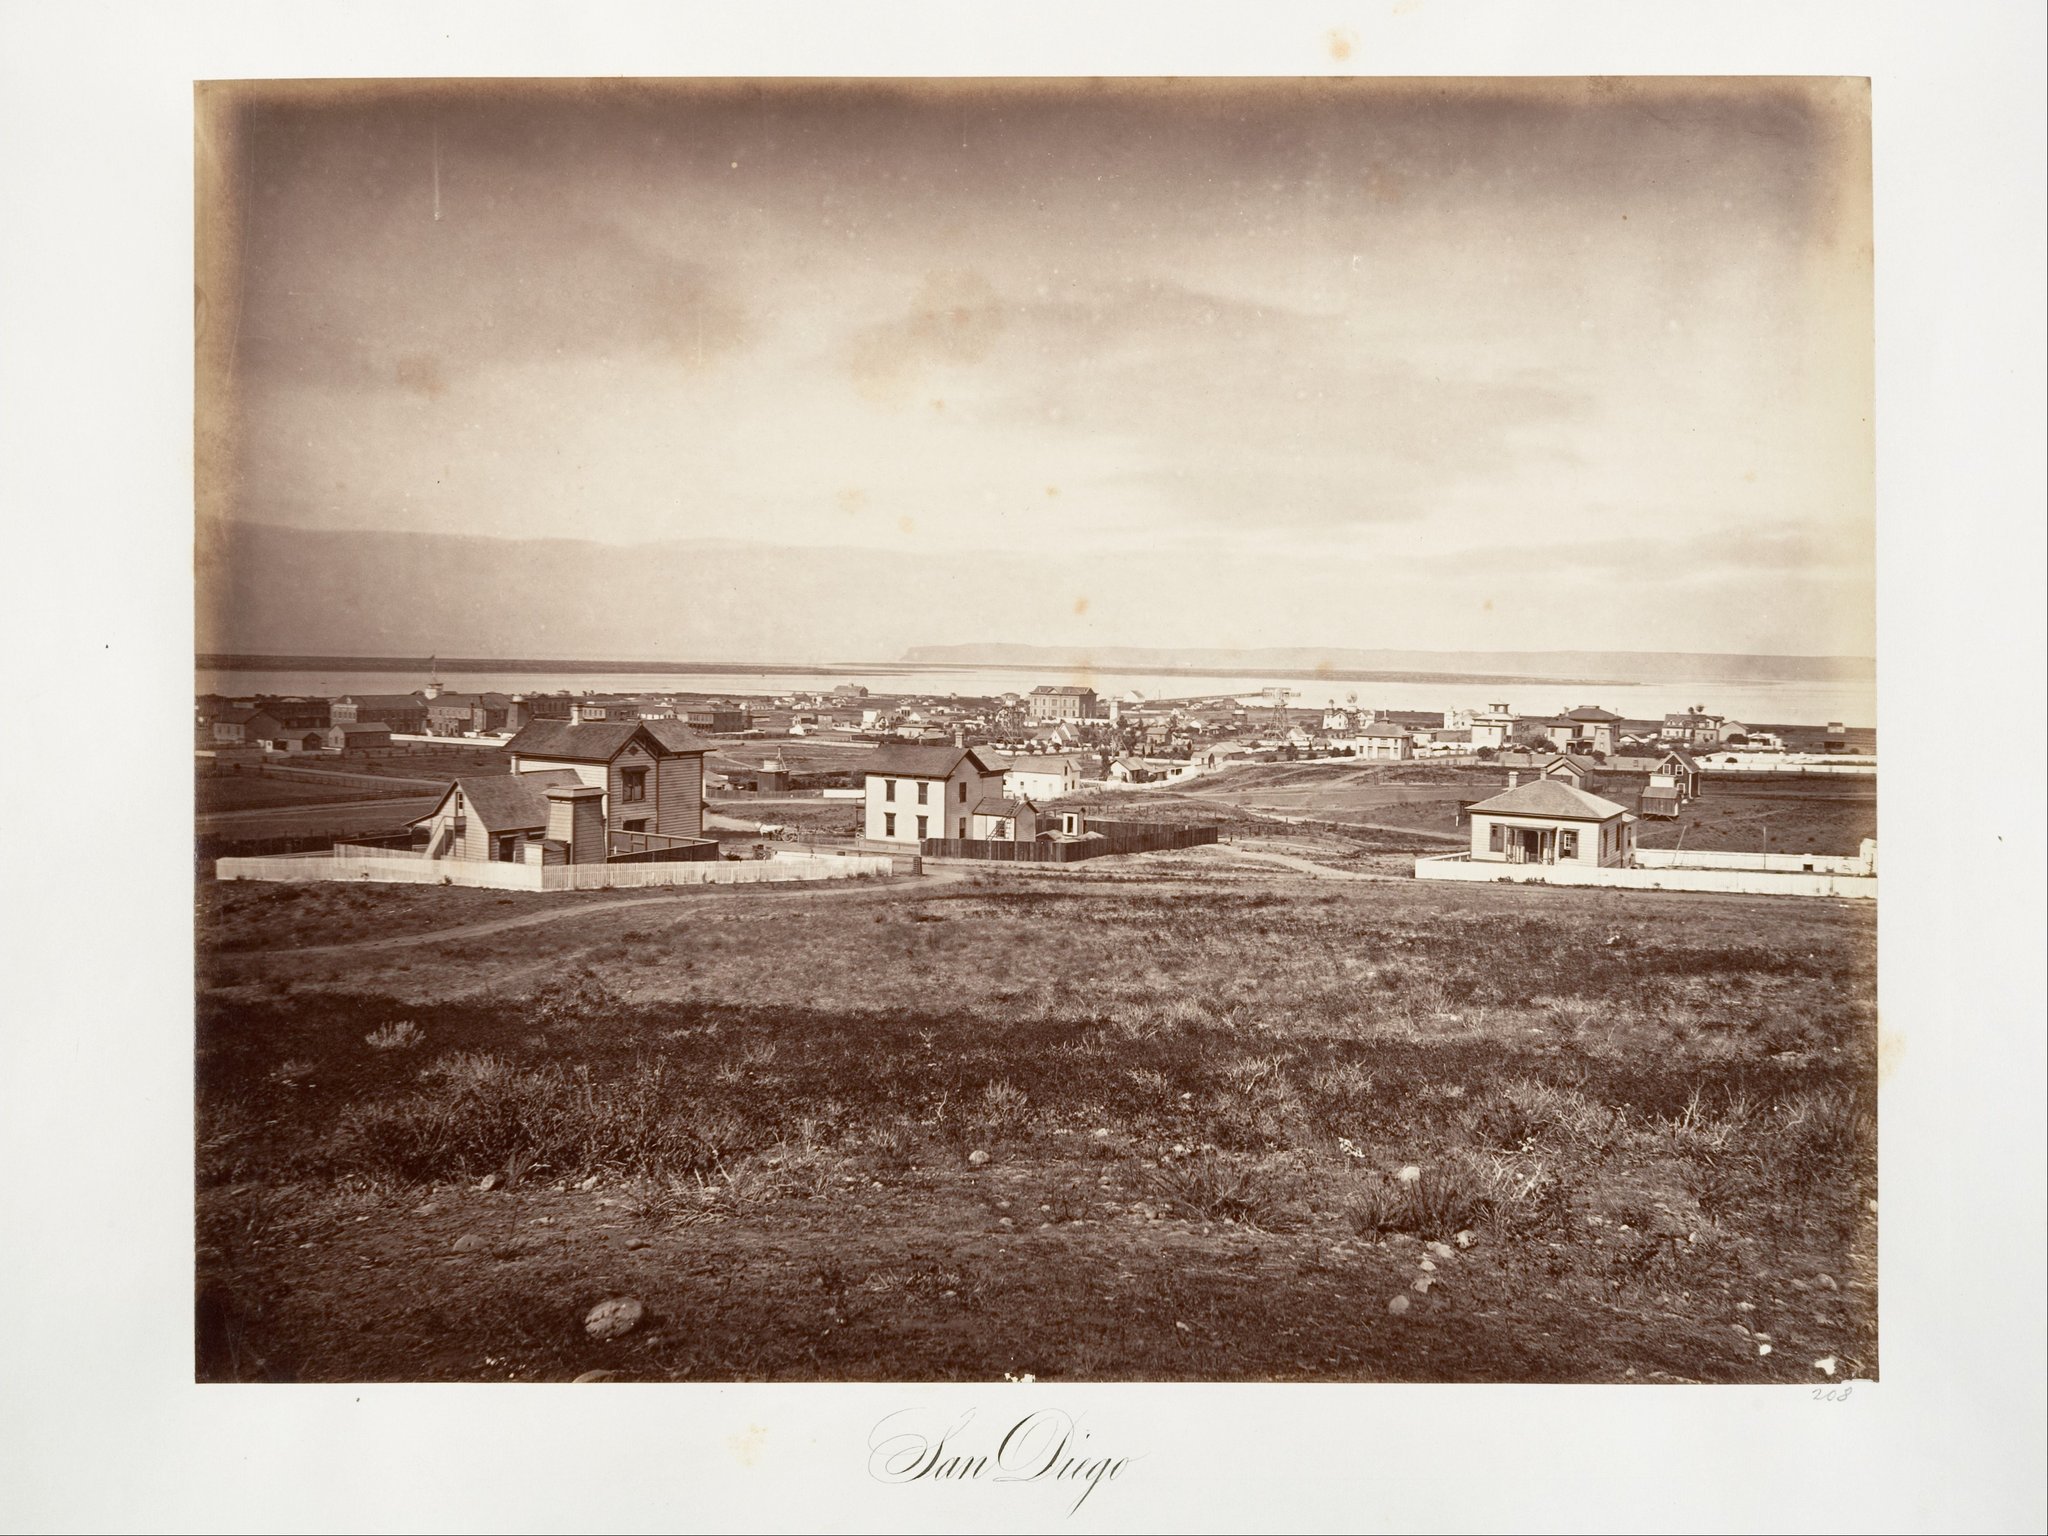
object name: photograph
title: San Diego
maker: carleton e. watkins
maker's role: artist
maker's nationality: american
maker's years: 1829-1916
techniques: albumen silver print, glass negative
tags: houses,landscapes